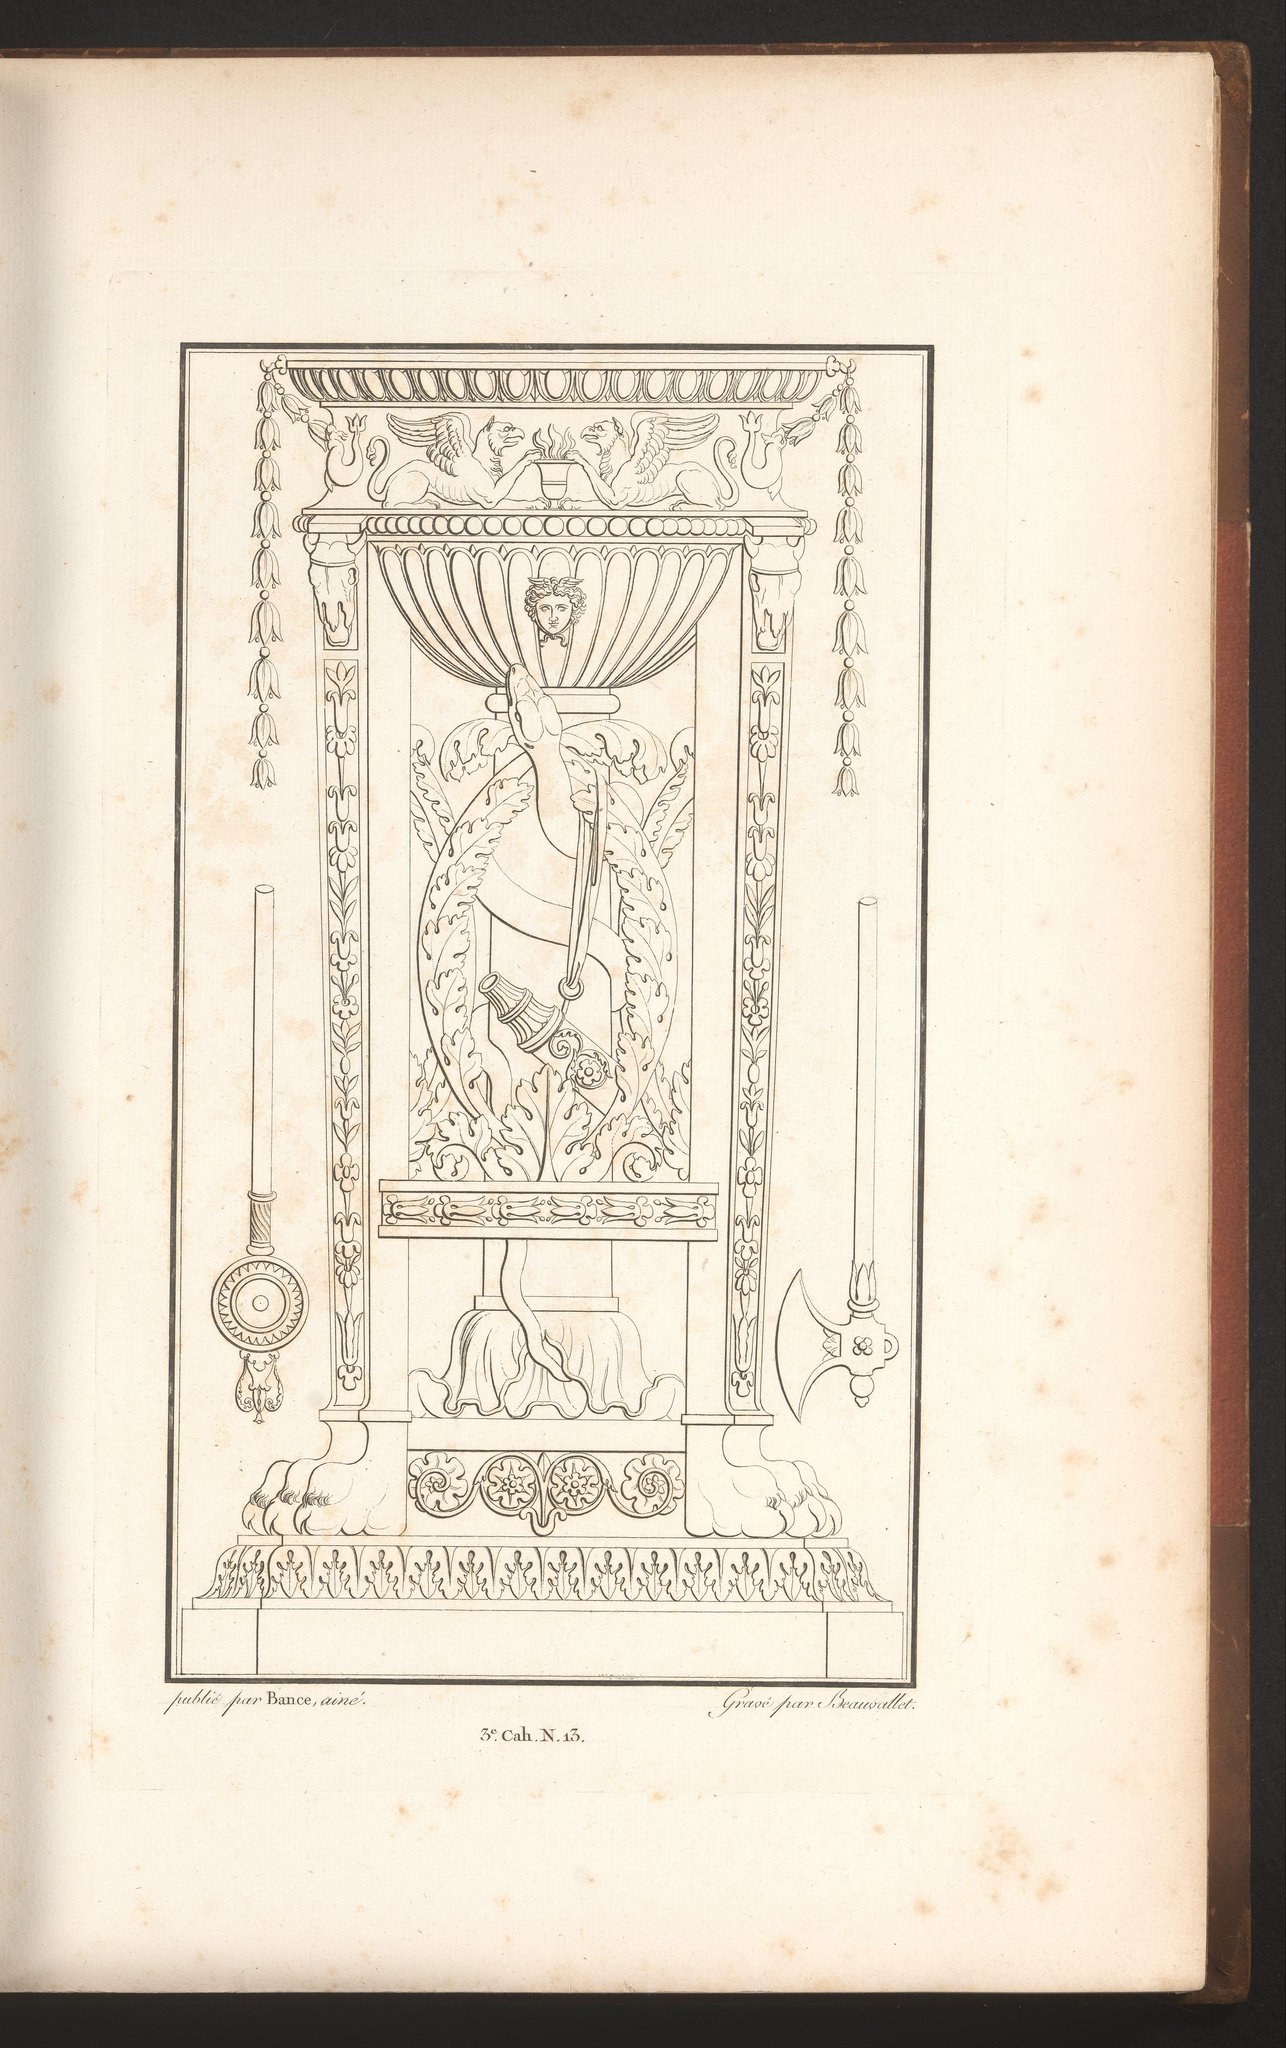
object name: ornament print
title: Wandornament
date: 1820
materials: paper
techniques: etching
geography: paris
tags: ornament derived from animal forms, ornament derived from objects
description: Ornamentprent met wandversiering met slang en offerschaal. Onderdeel (3e. Cah. N. 13) van het prentalbum met twee series van in totaal 138 ornamentprenten door Beauvallet en Normand, 'Fragmens d'Ornemens dans le Style Antique'.